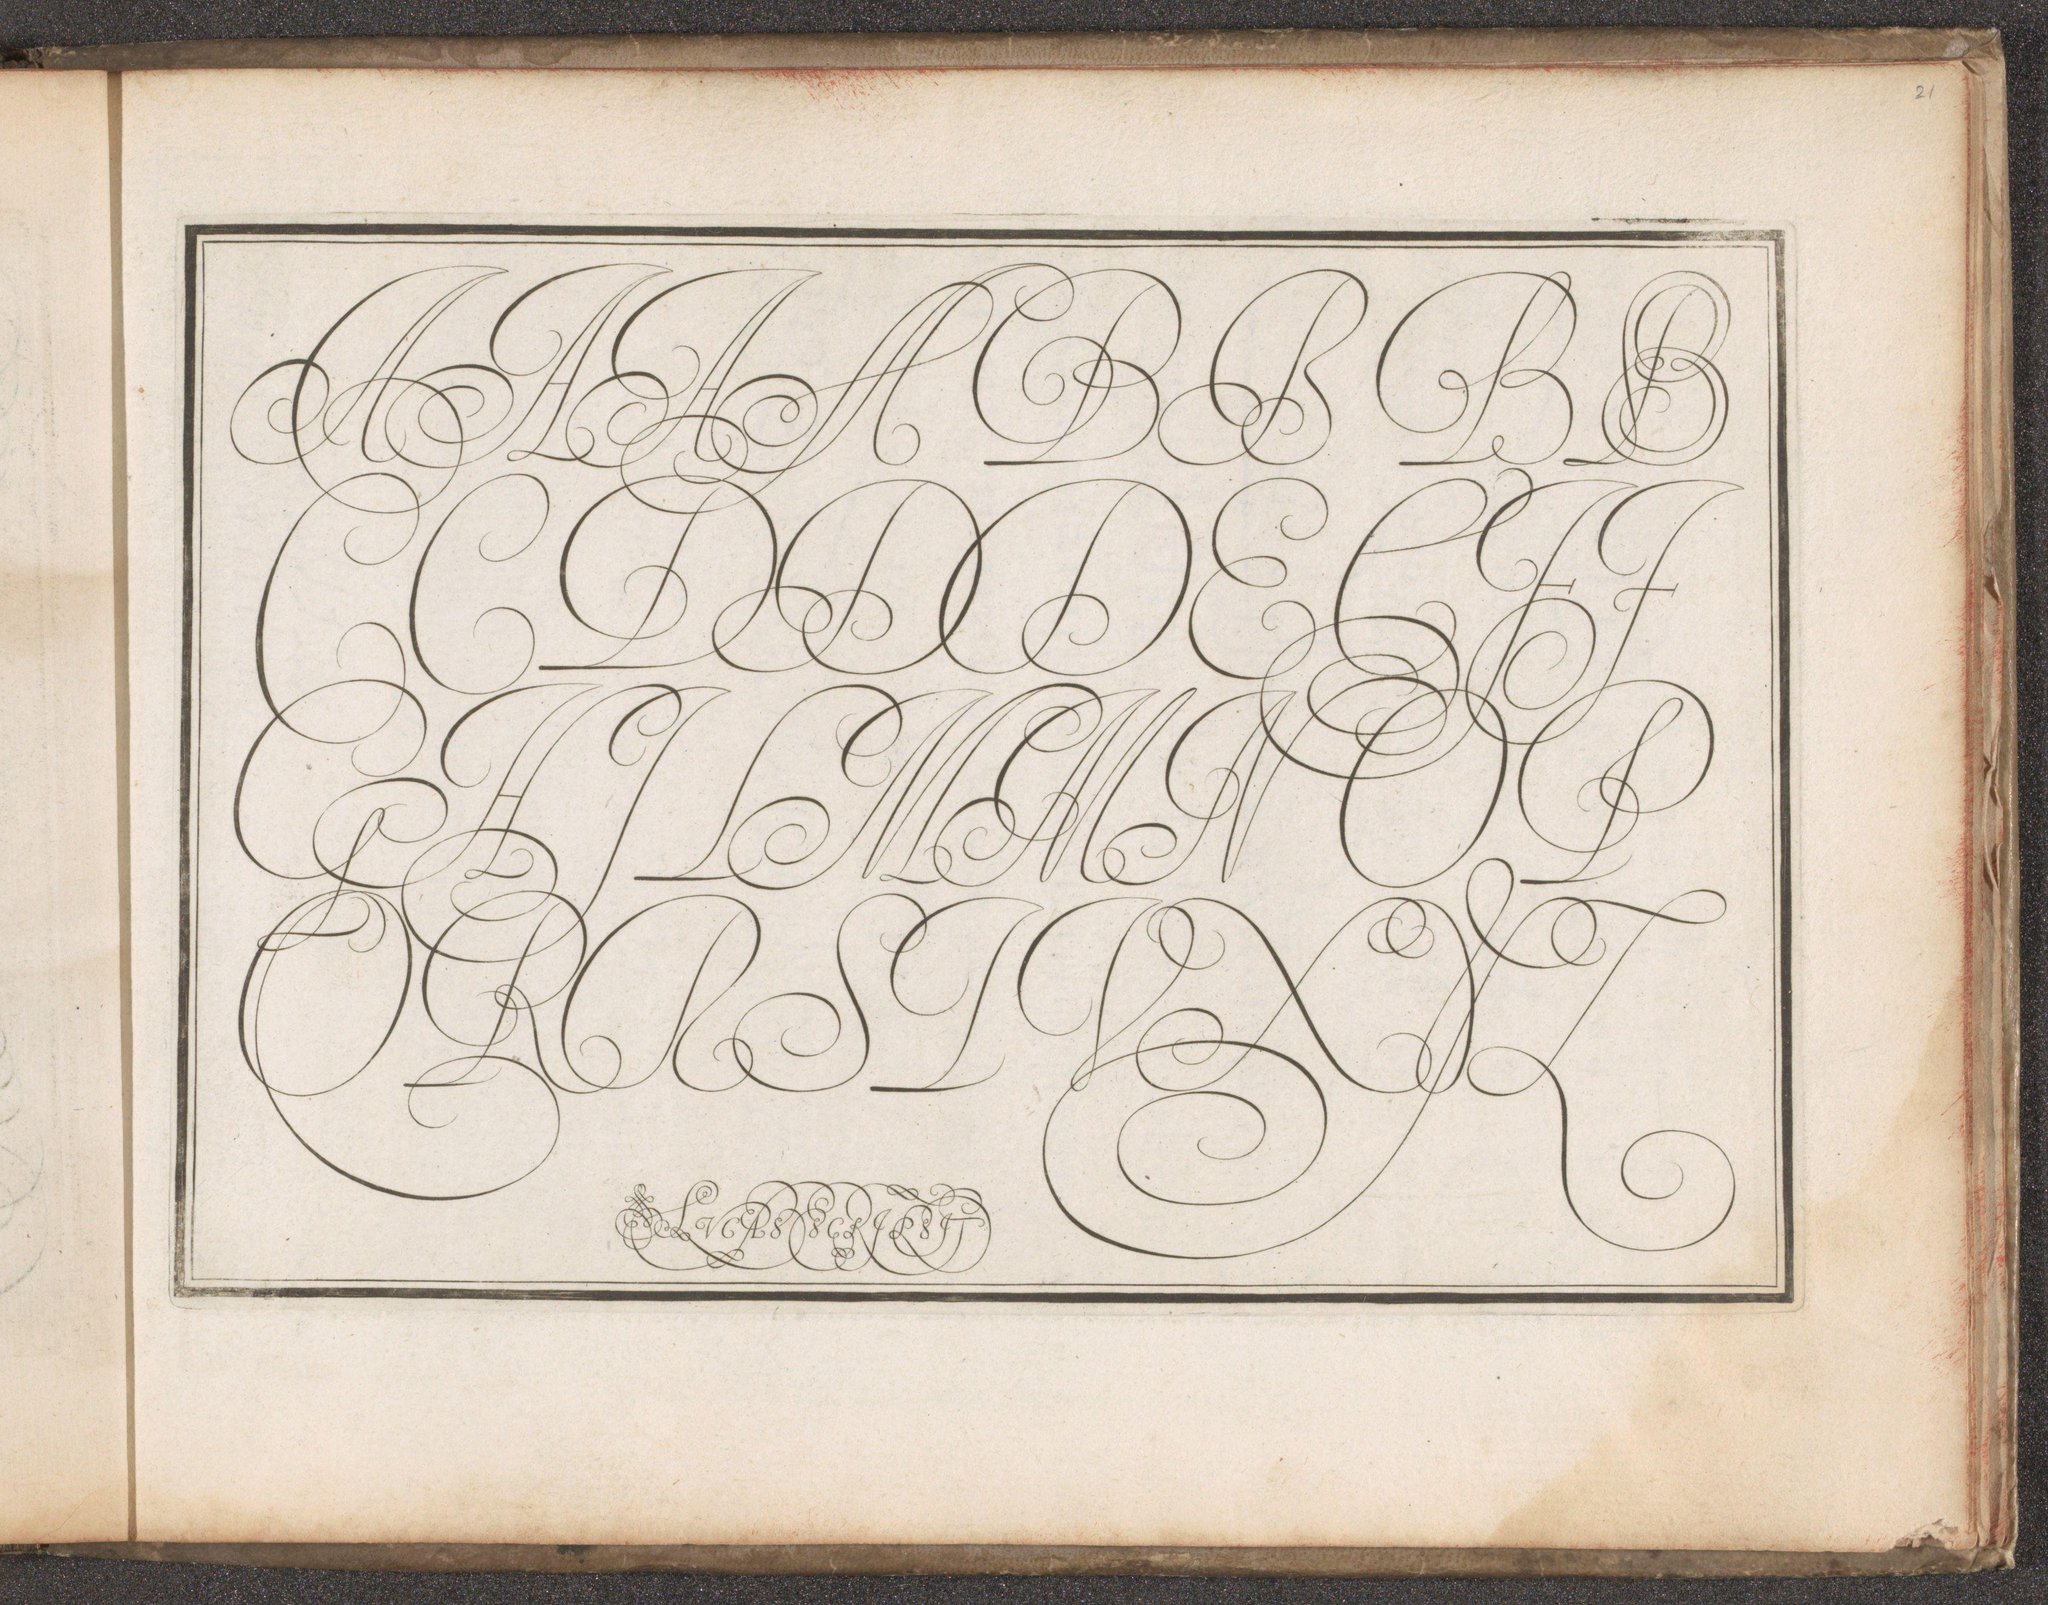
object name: album leaf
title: Schrijfvoorbeeld met het alfabet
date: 1608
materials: paper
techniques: engraving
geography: avignon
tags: calligraphy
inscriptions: signature and date: ‘Op titelblad: Judoco Hondio celatore. Amstelodami apud Joannem Janssonium. 1614’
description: Schrijfvoorbeeld met het alfabet in kapitalen in vier regels. De prent maakt deel uit van een album.